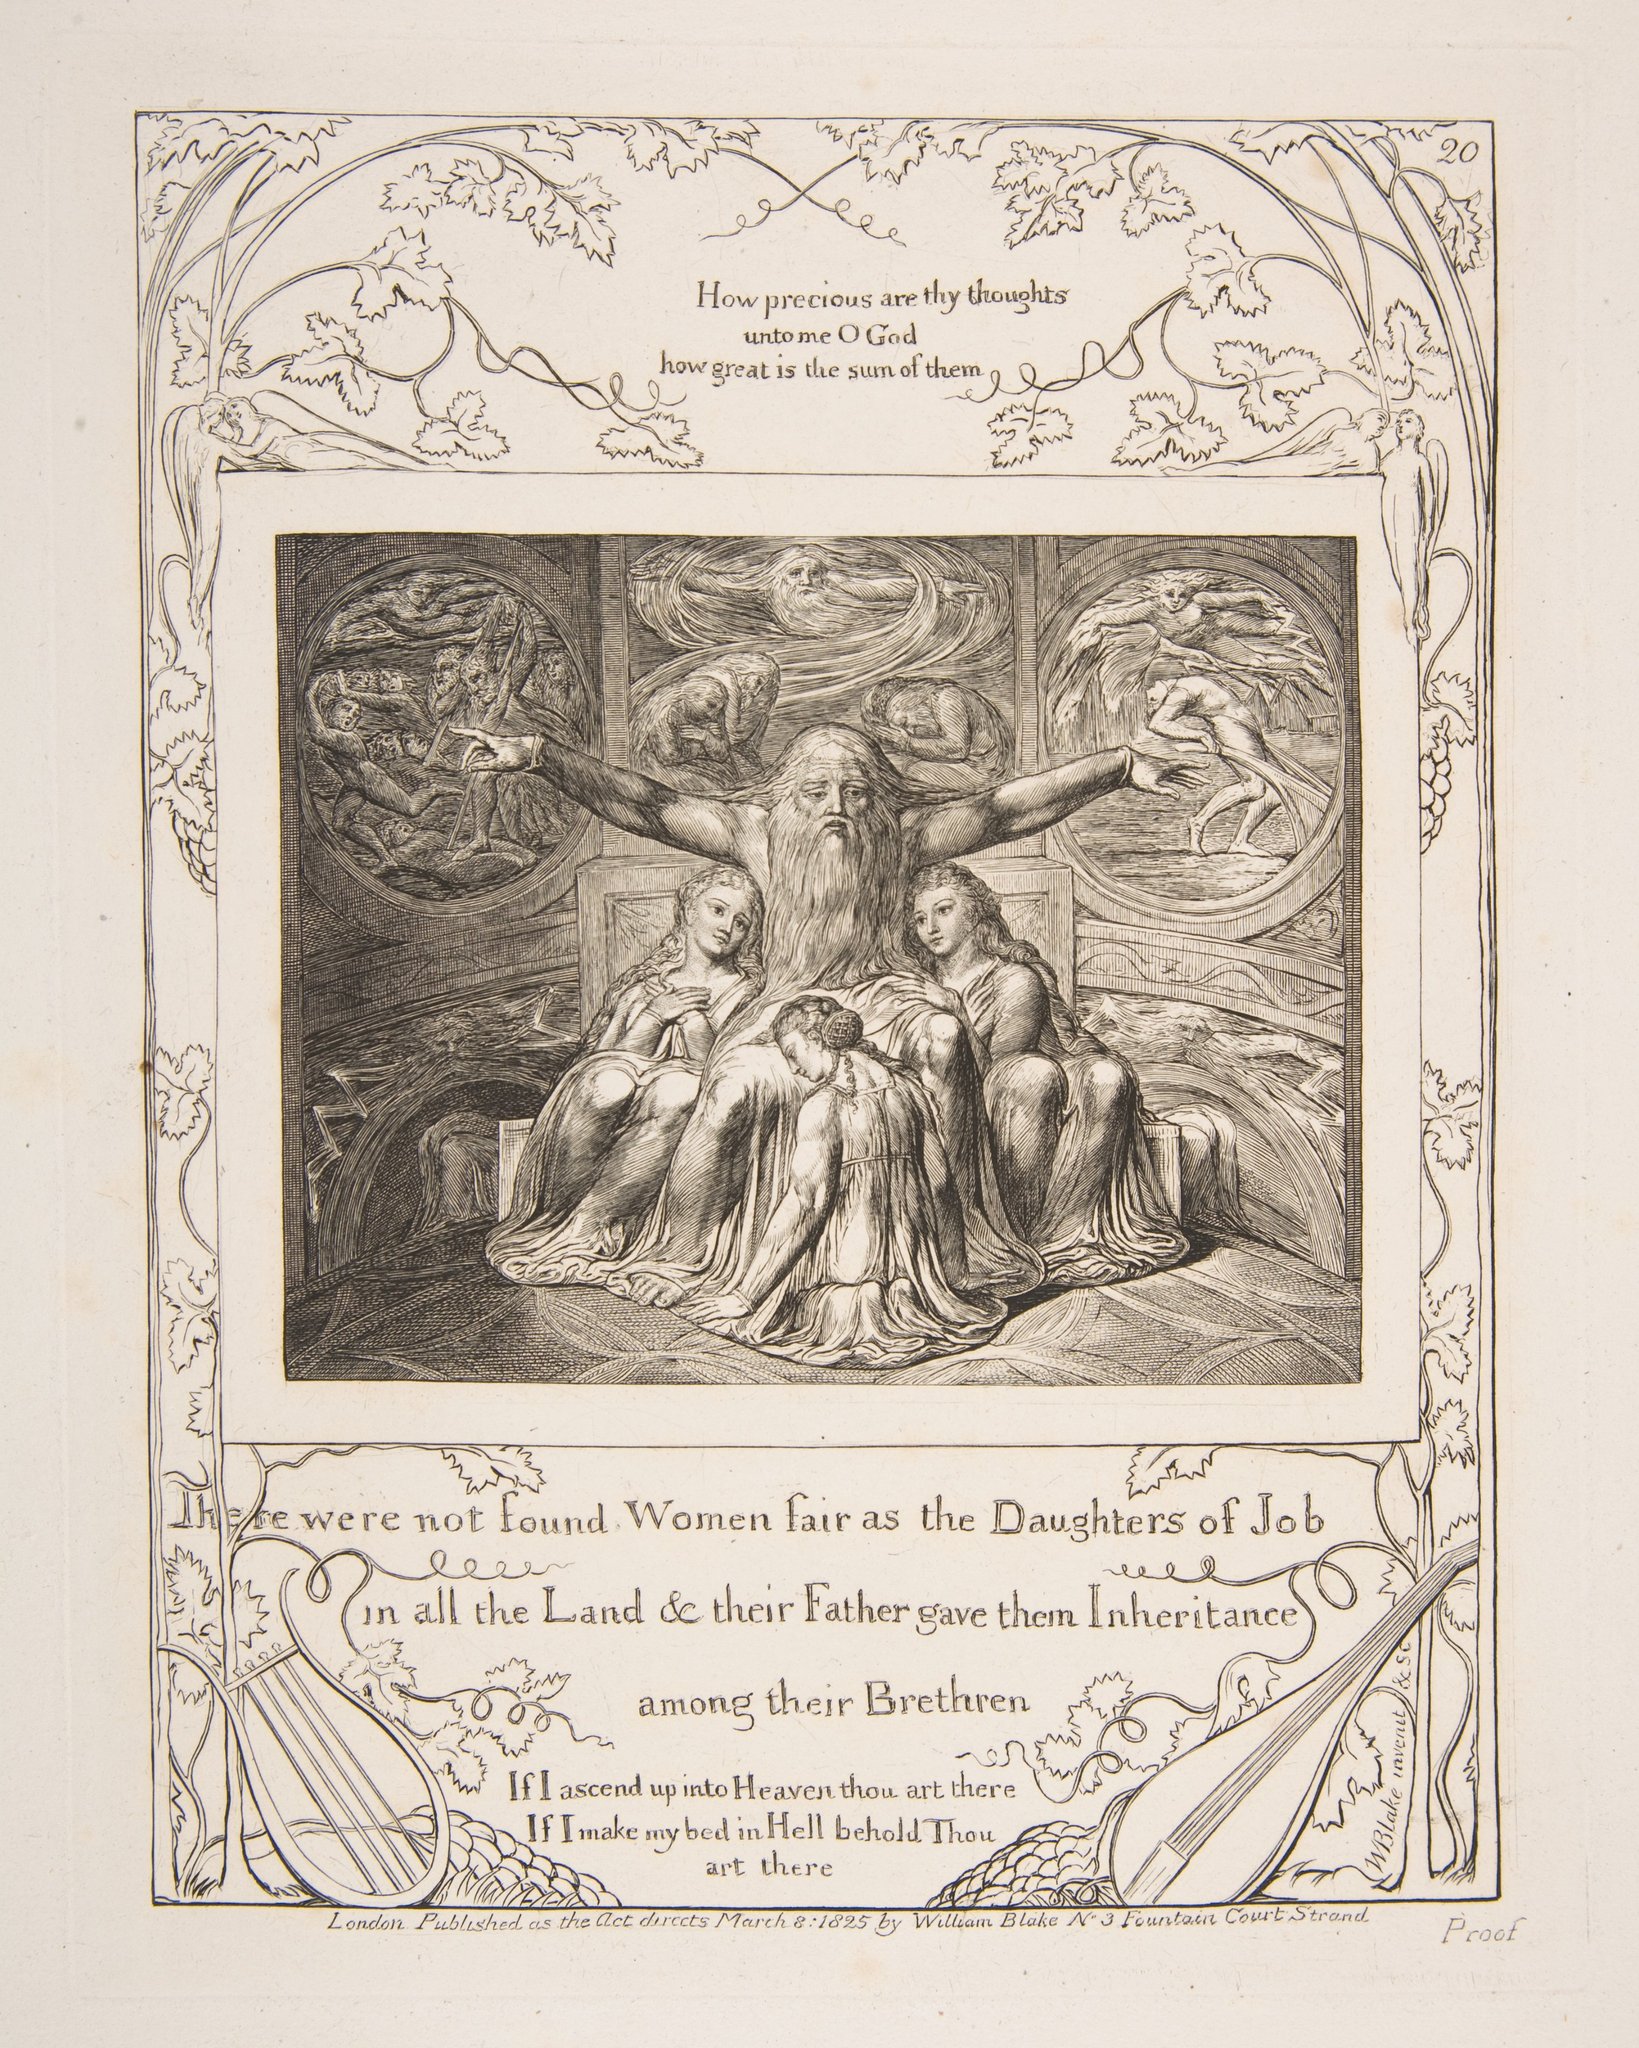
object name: print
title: Job and his Daughters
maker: william blake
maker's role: artist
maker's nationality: british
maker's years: 1757-1827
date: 1825-1826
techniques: engraving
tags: girls,job